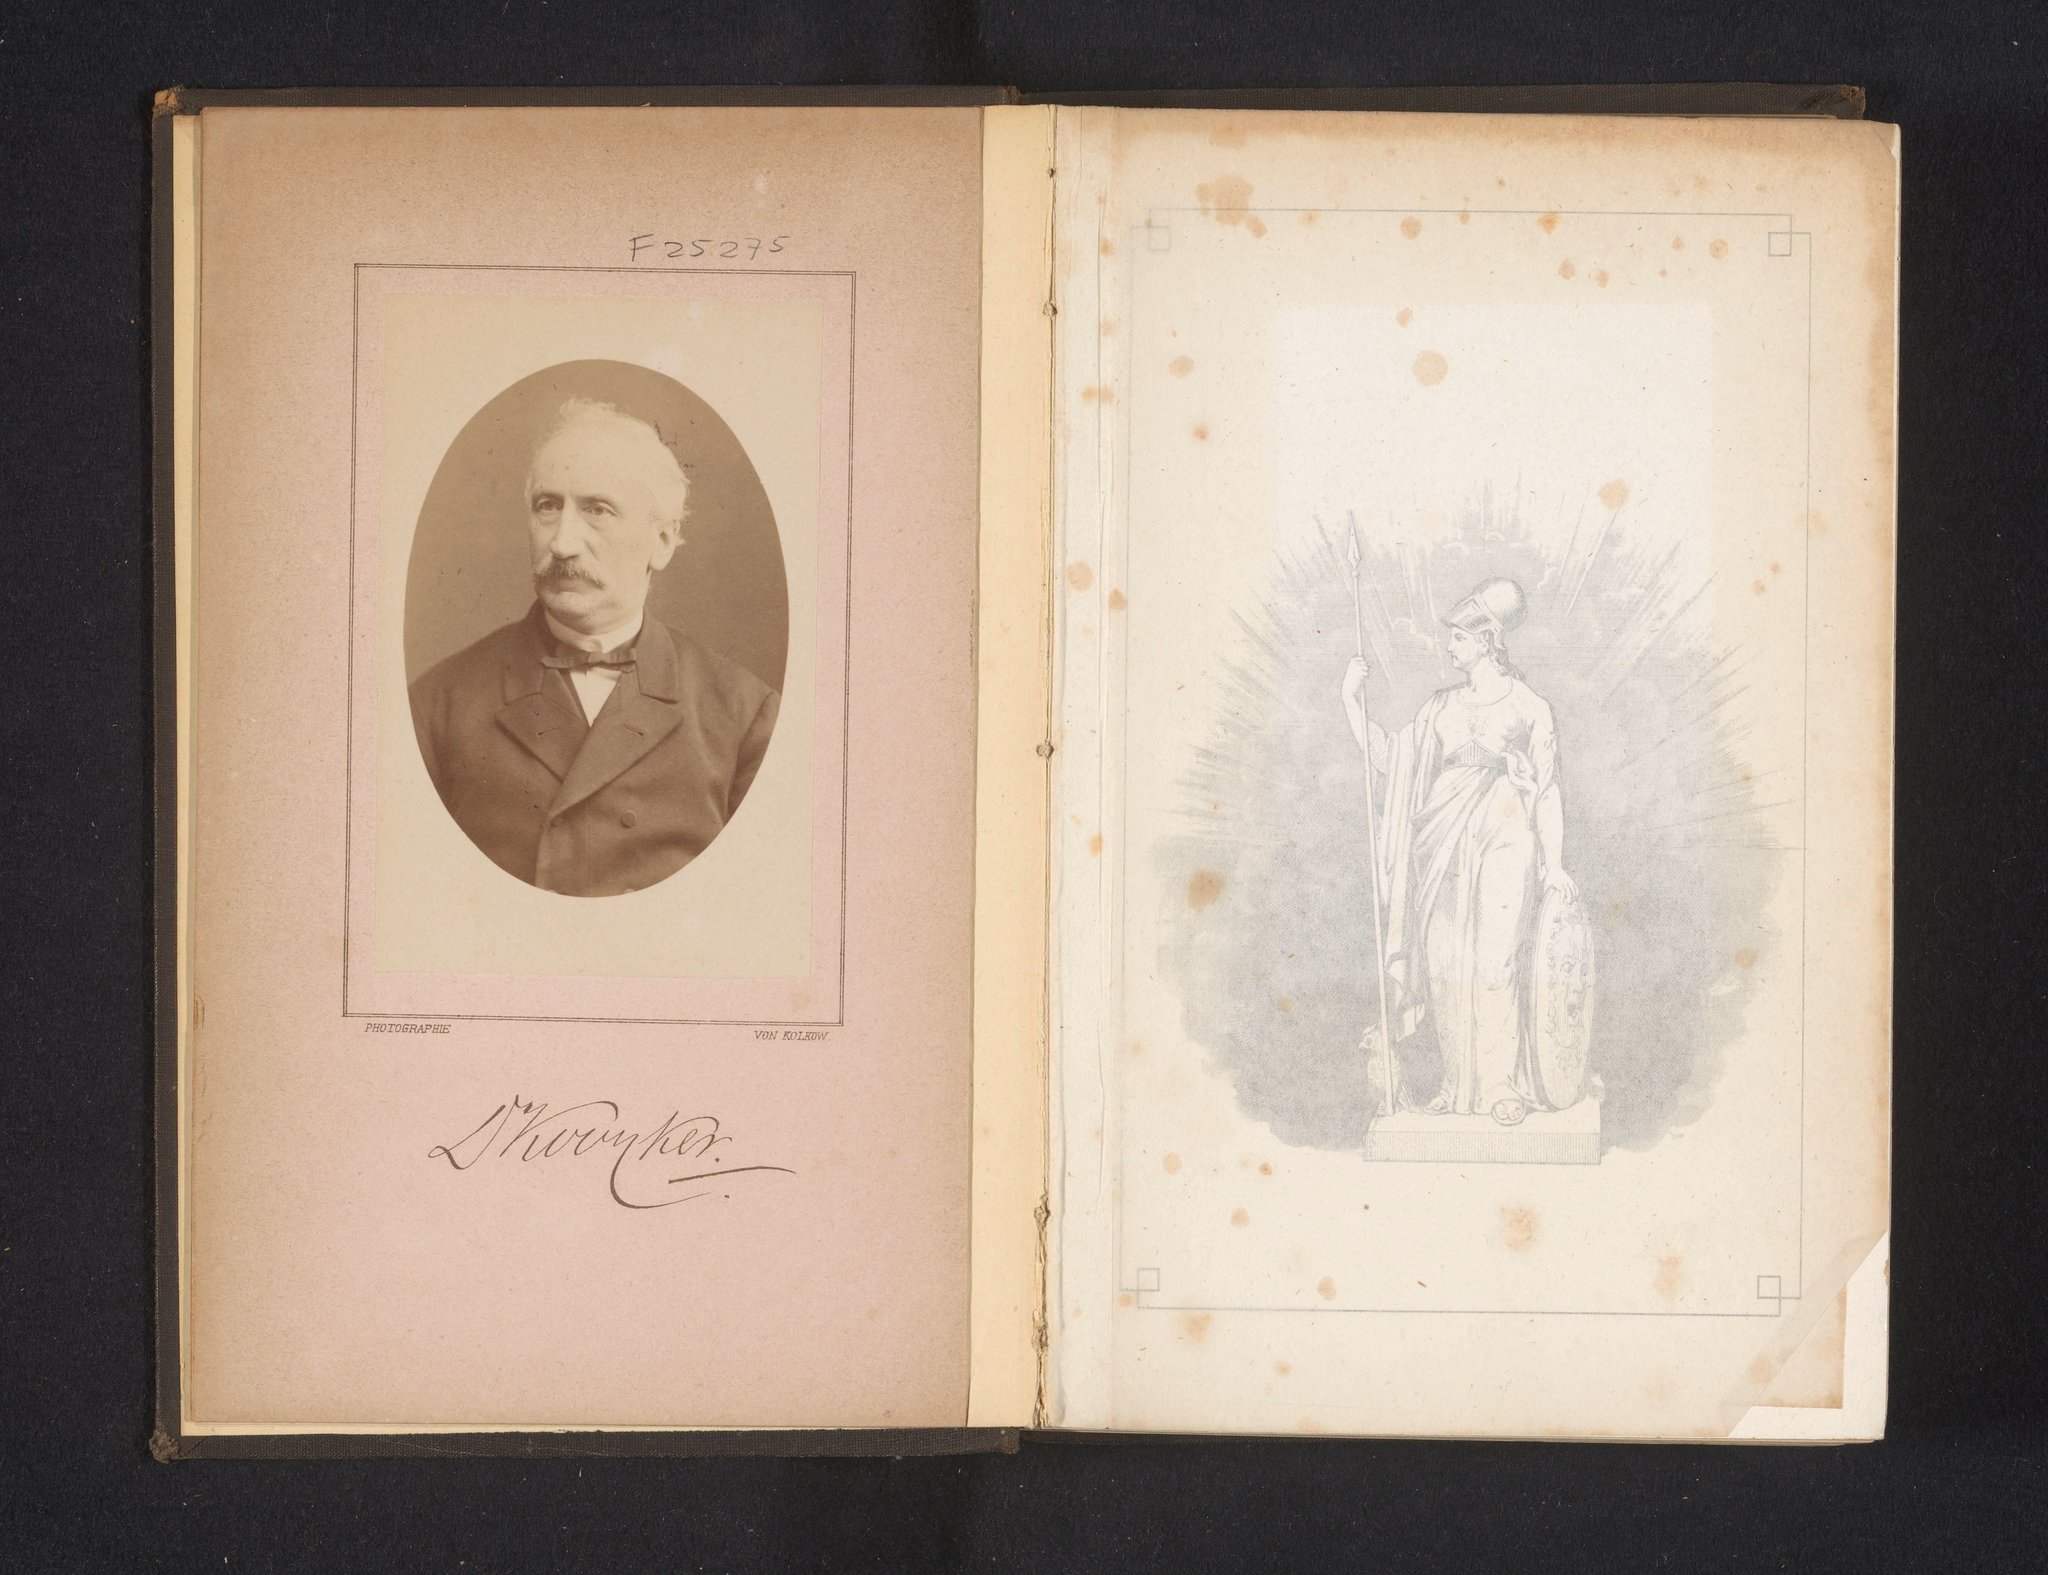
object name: photograph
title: Portret van Hendrik Albert Kooyker, hoogleraar geneeskunde in Groningen en rector magnificus van 1884 tot 1885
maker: friedrich julius von kolkow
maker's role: fotograaf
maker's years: 1839-1914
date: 1880-1885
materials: photographic support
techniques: albumen print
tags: amsterdam, historical persons, professor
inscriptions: name: ‘Dr Kooyker.’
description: Foto op derde ongenummerde pagina voor titelpagina.